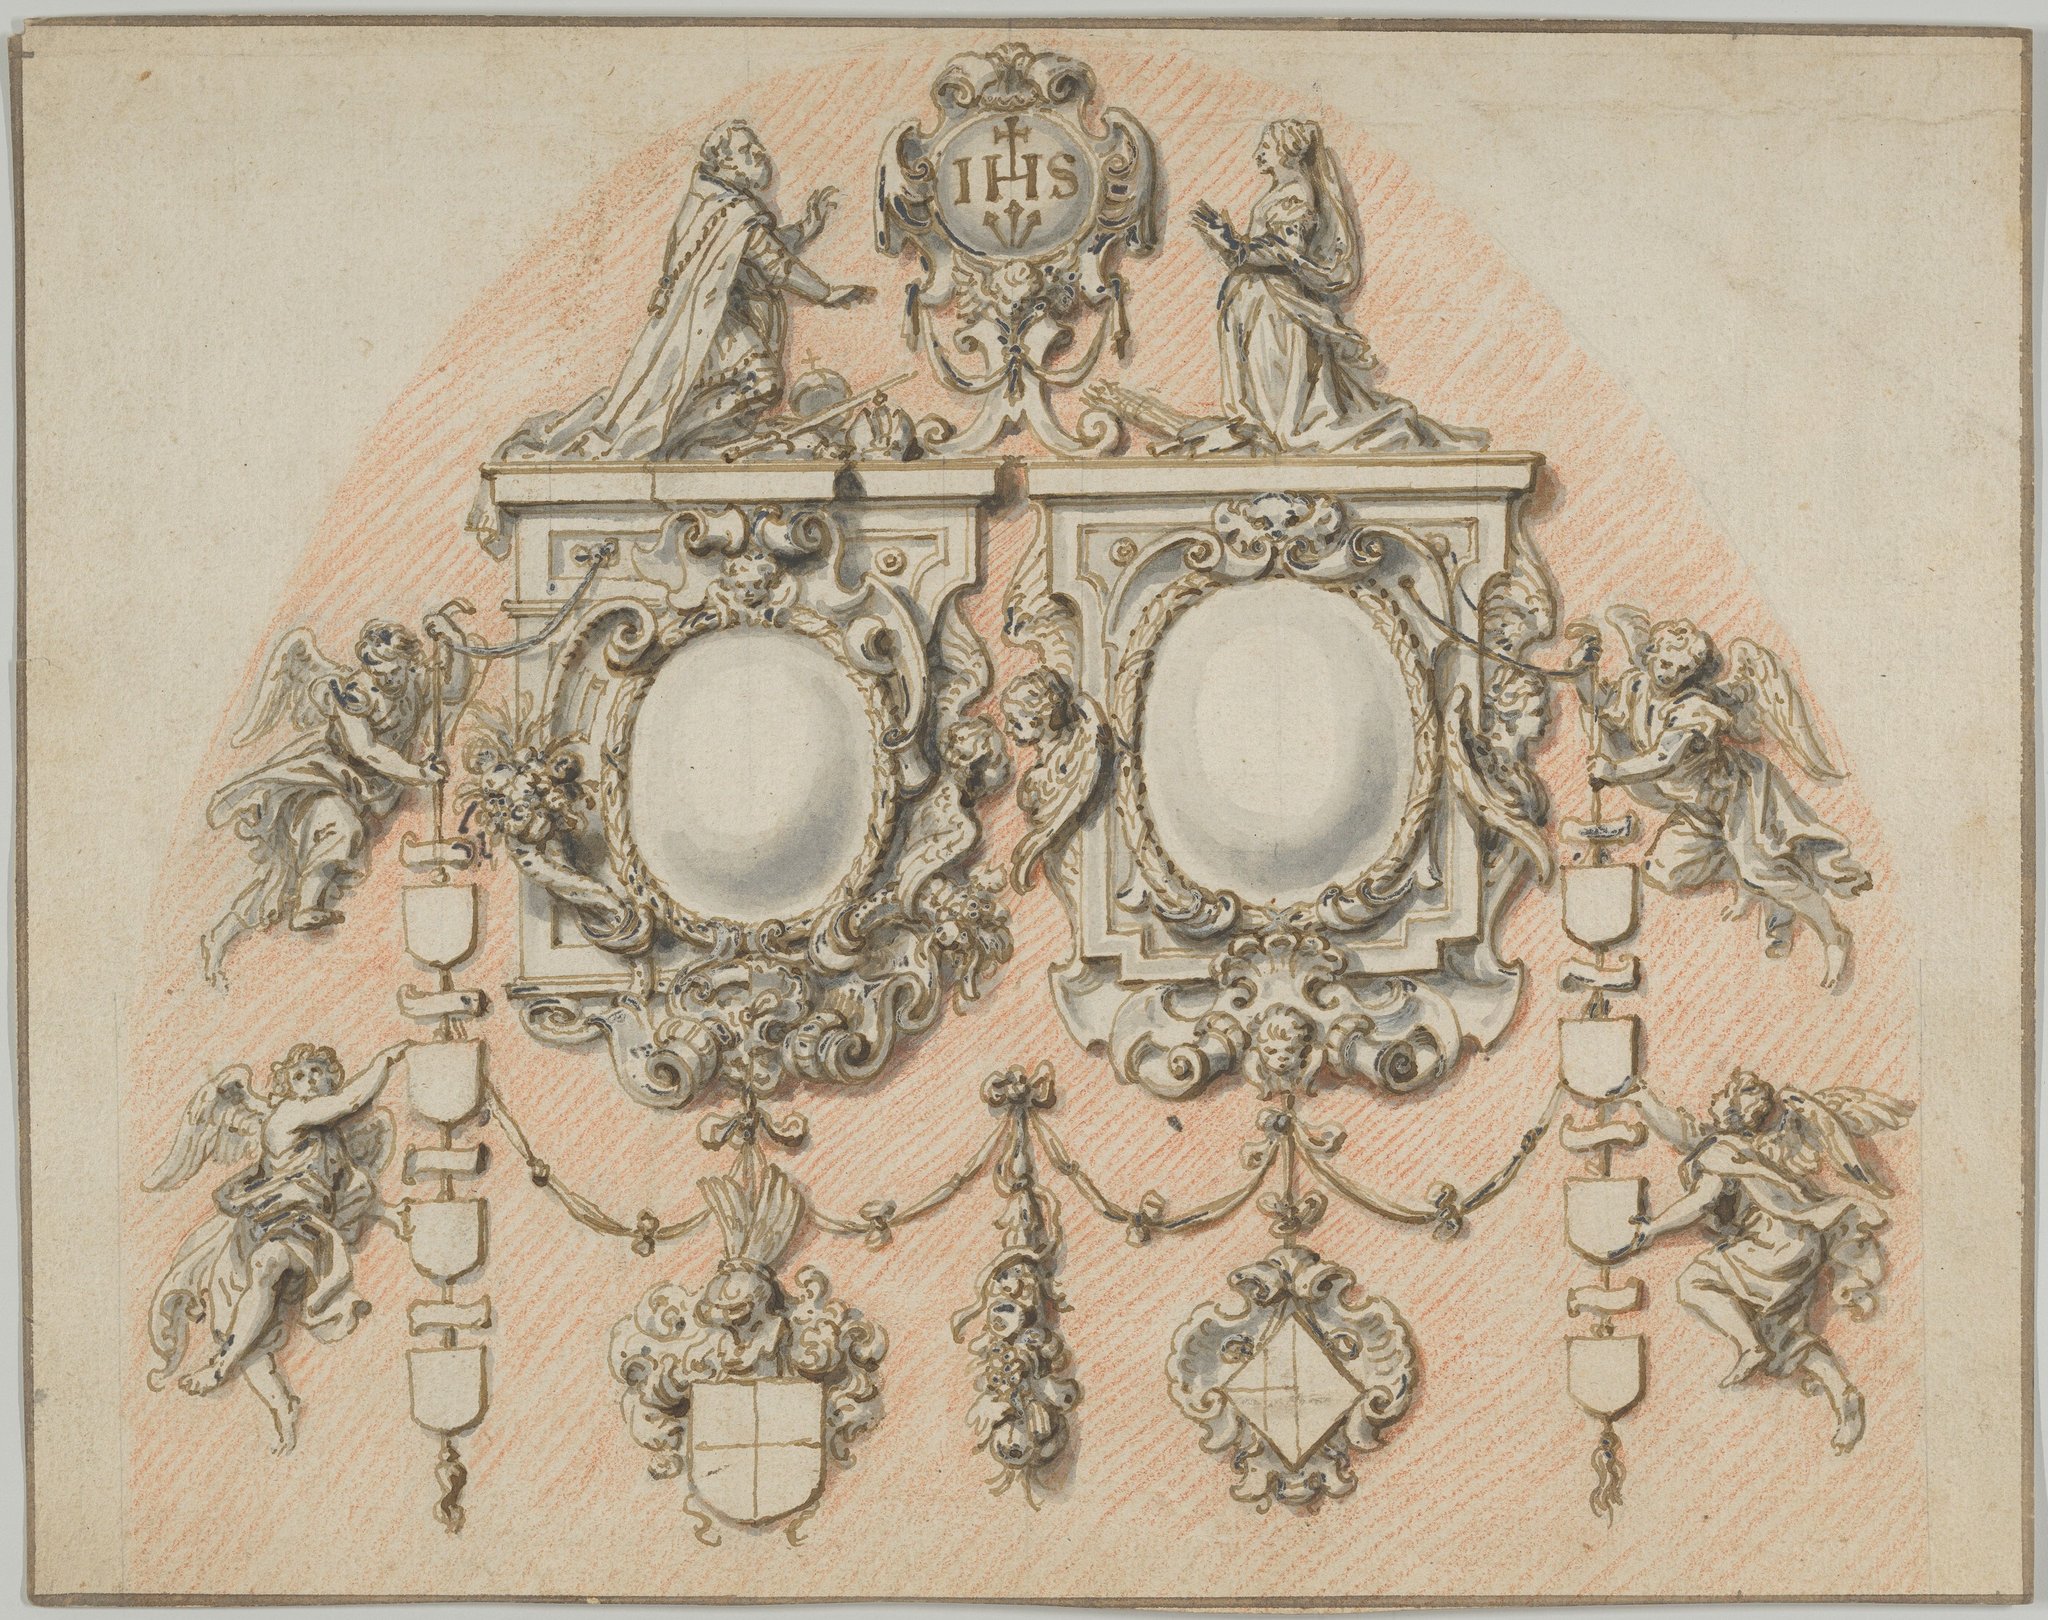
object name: drawing ornament architecture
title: Design for the Epitaph of the 't Seraets-Van Etten family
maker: abraham van diepenbeeck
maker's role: artist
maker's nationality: flemish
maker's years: 1596-1675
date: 1650-1675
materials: chalk, ink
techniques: heightening, pen, wash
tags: men,women,insignia